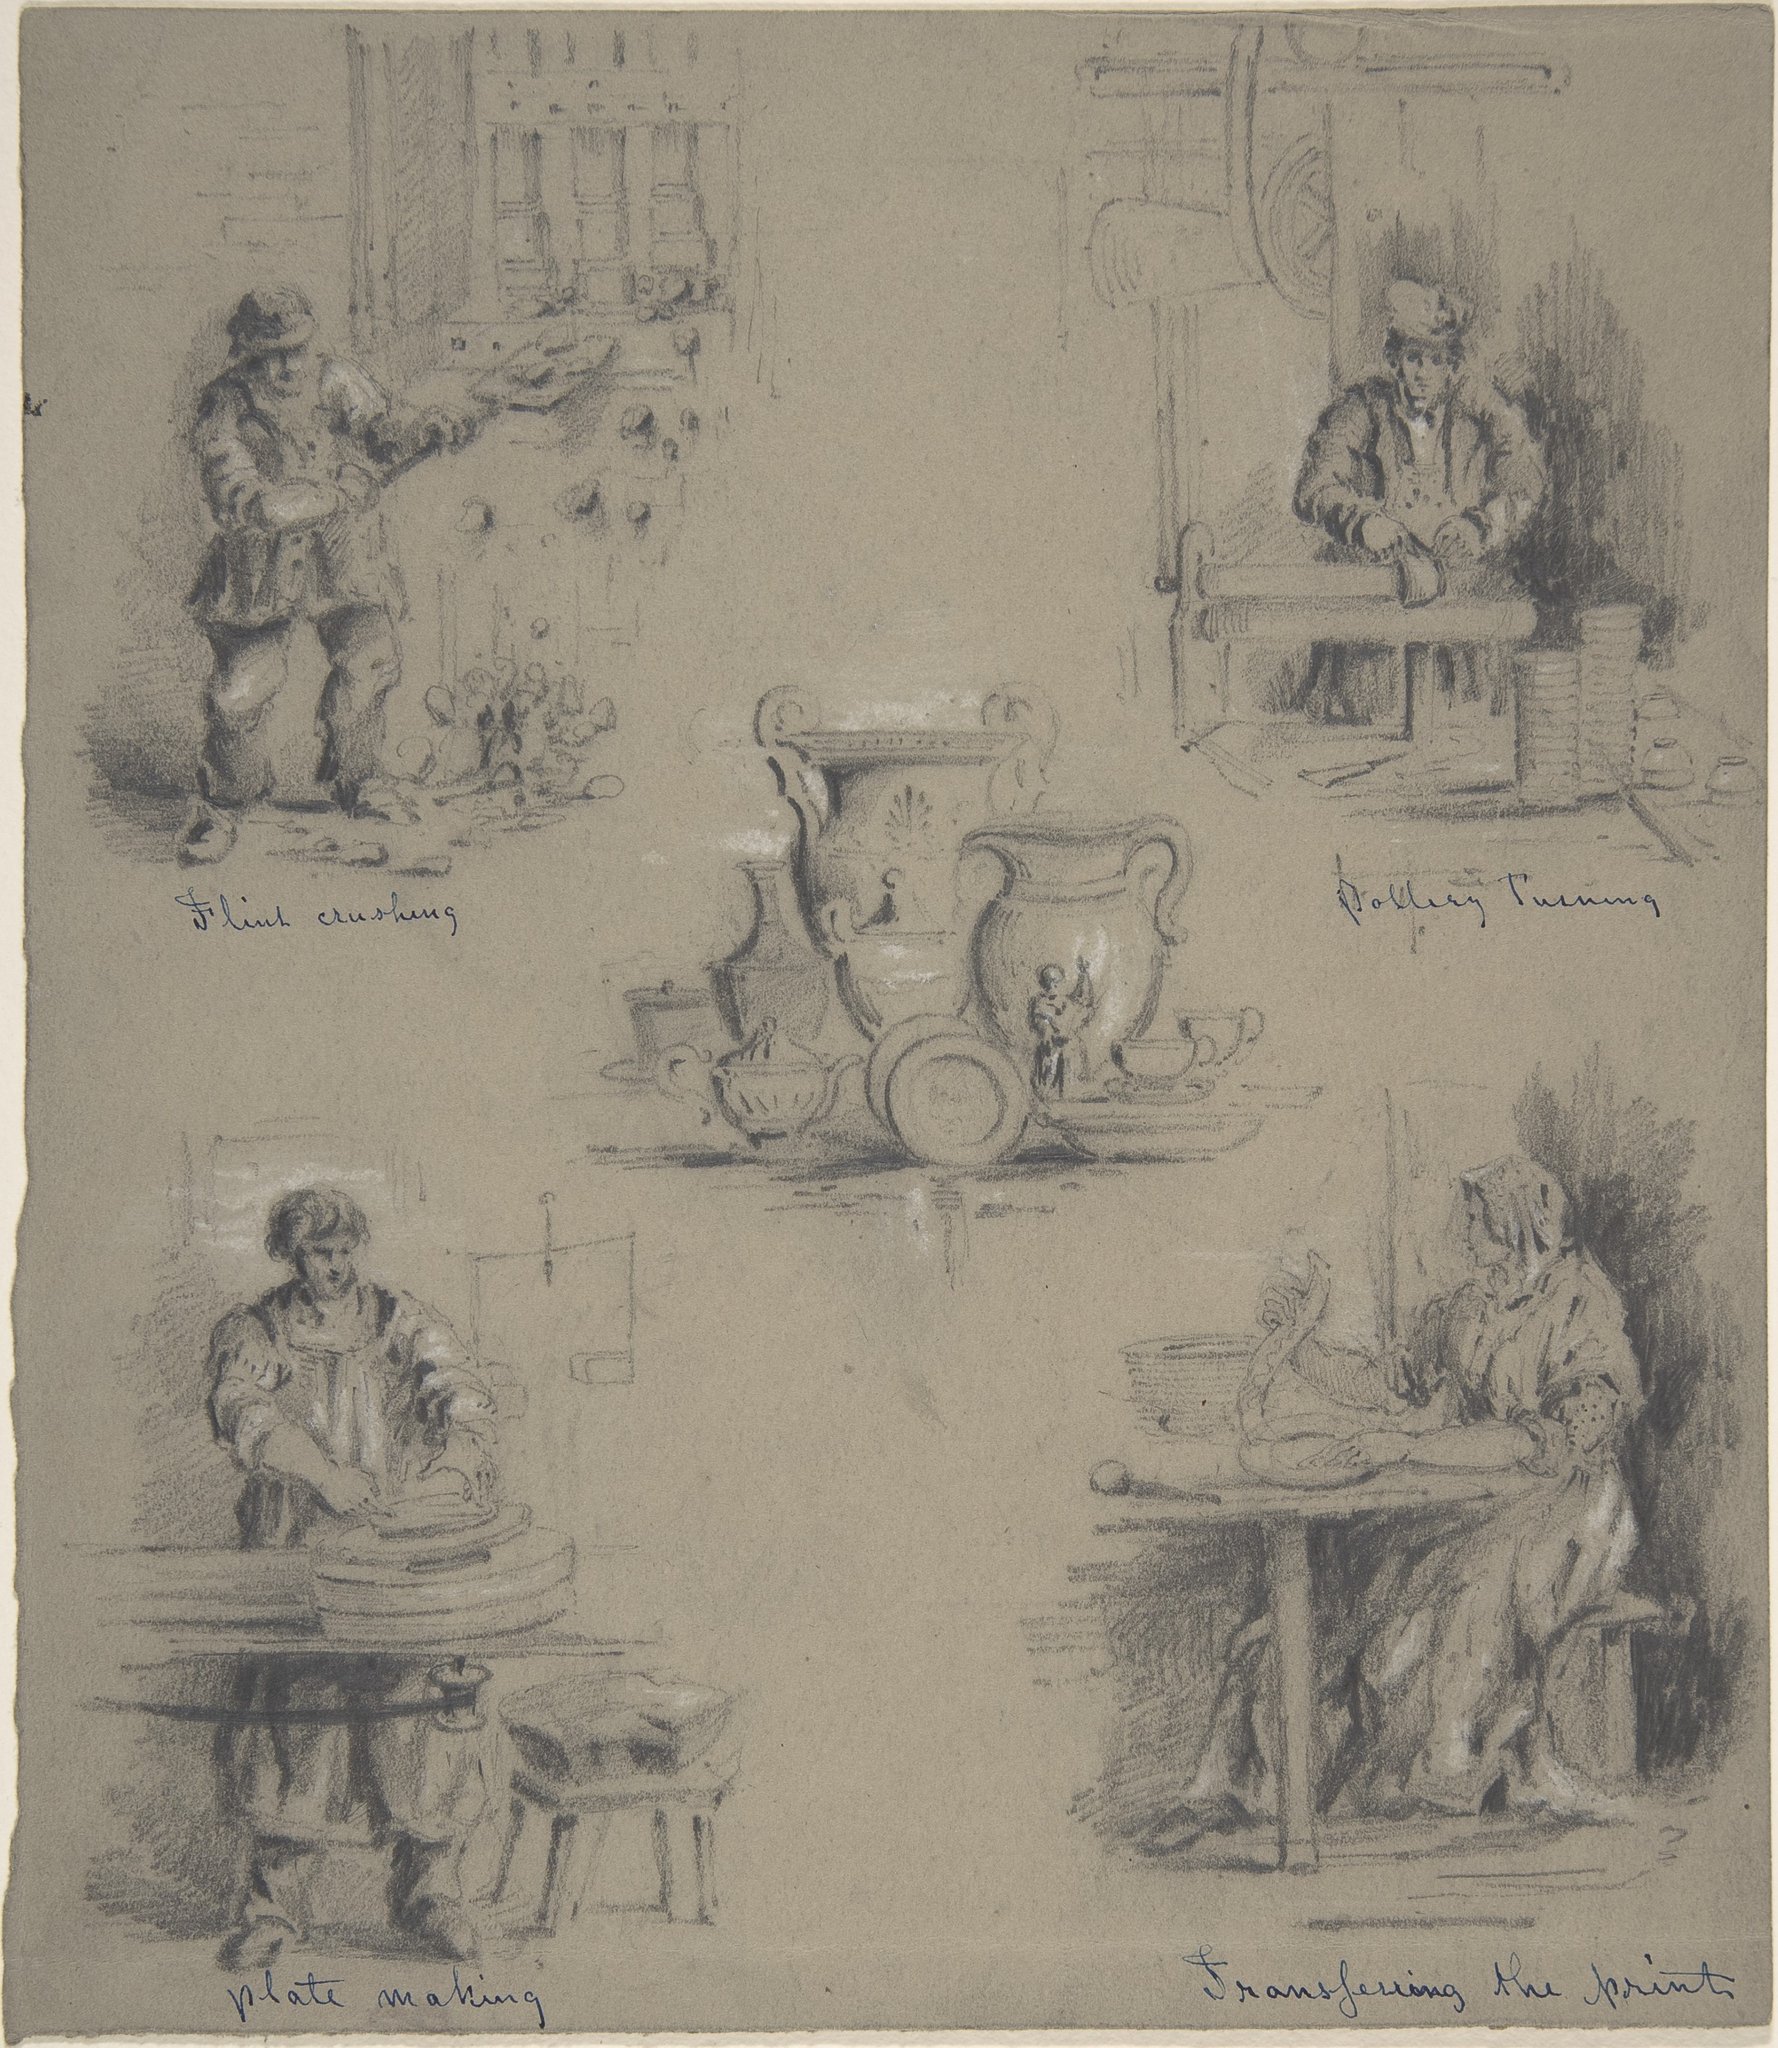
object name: drawing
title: Five drawings showing the manufacture of china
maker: anonymous, british, 19th century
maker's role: artist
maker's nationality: british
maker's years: 1800-1900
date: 1801-1900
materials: chalk, graphite, ink, paper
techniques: pen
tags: men,women,working